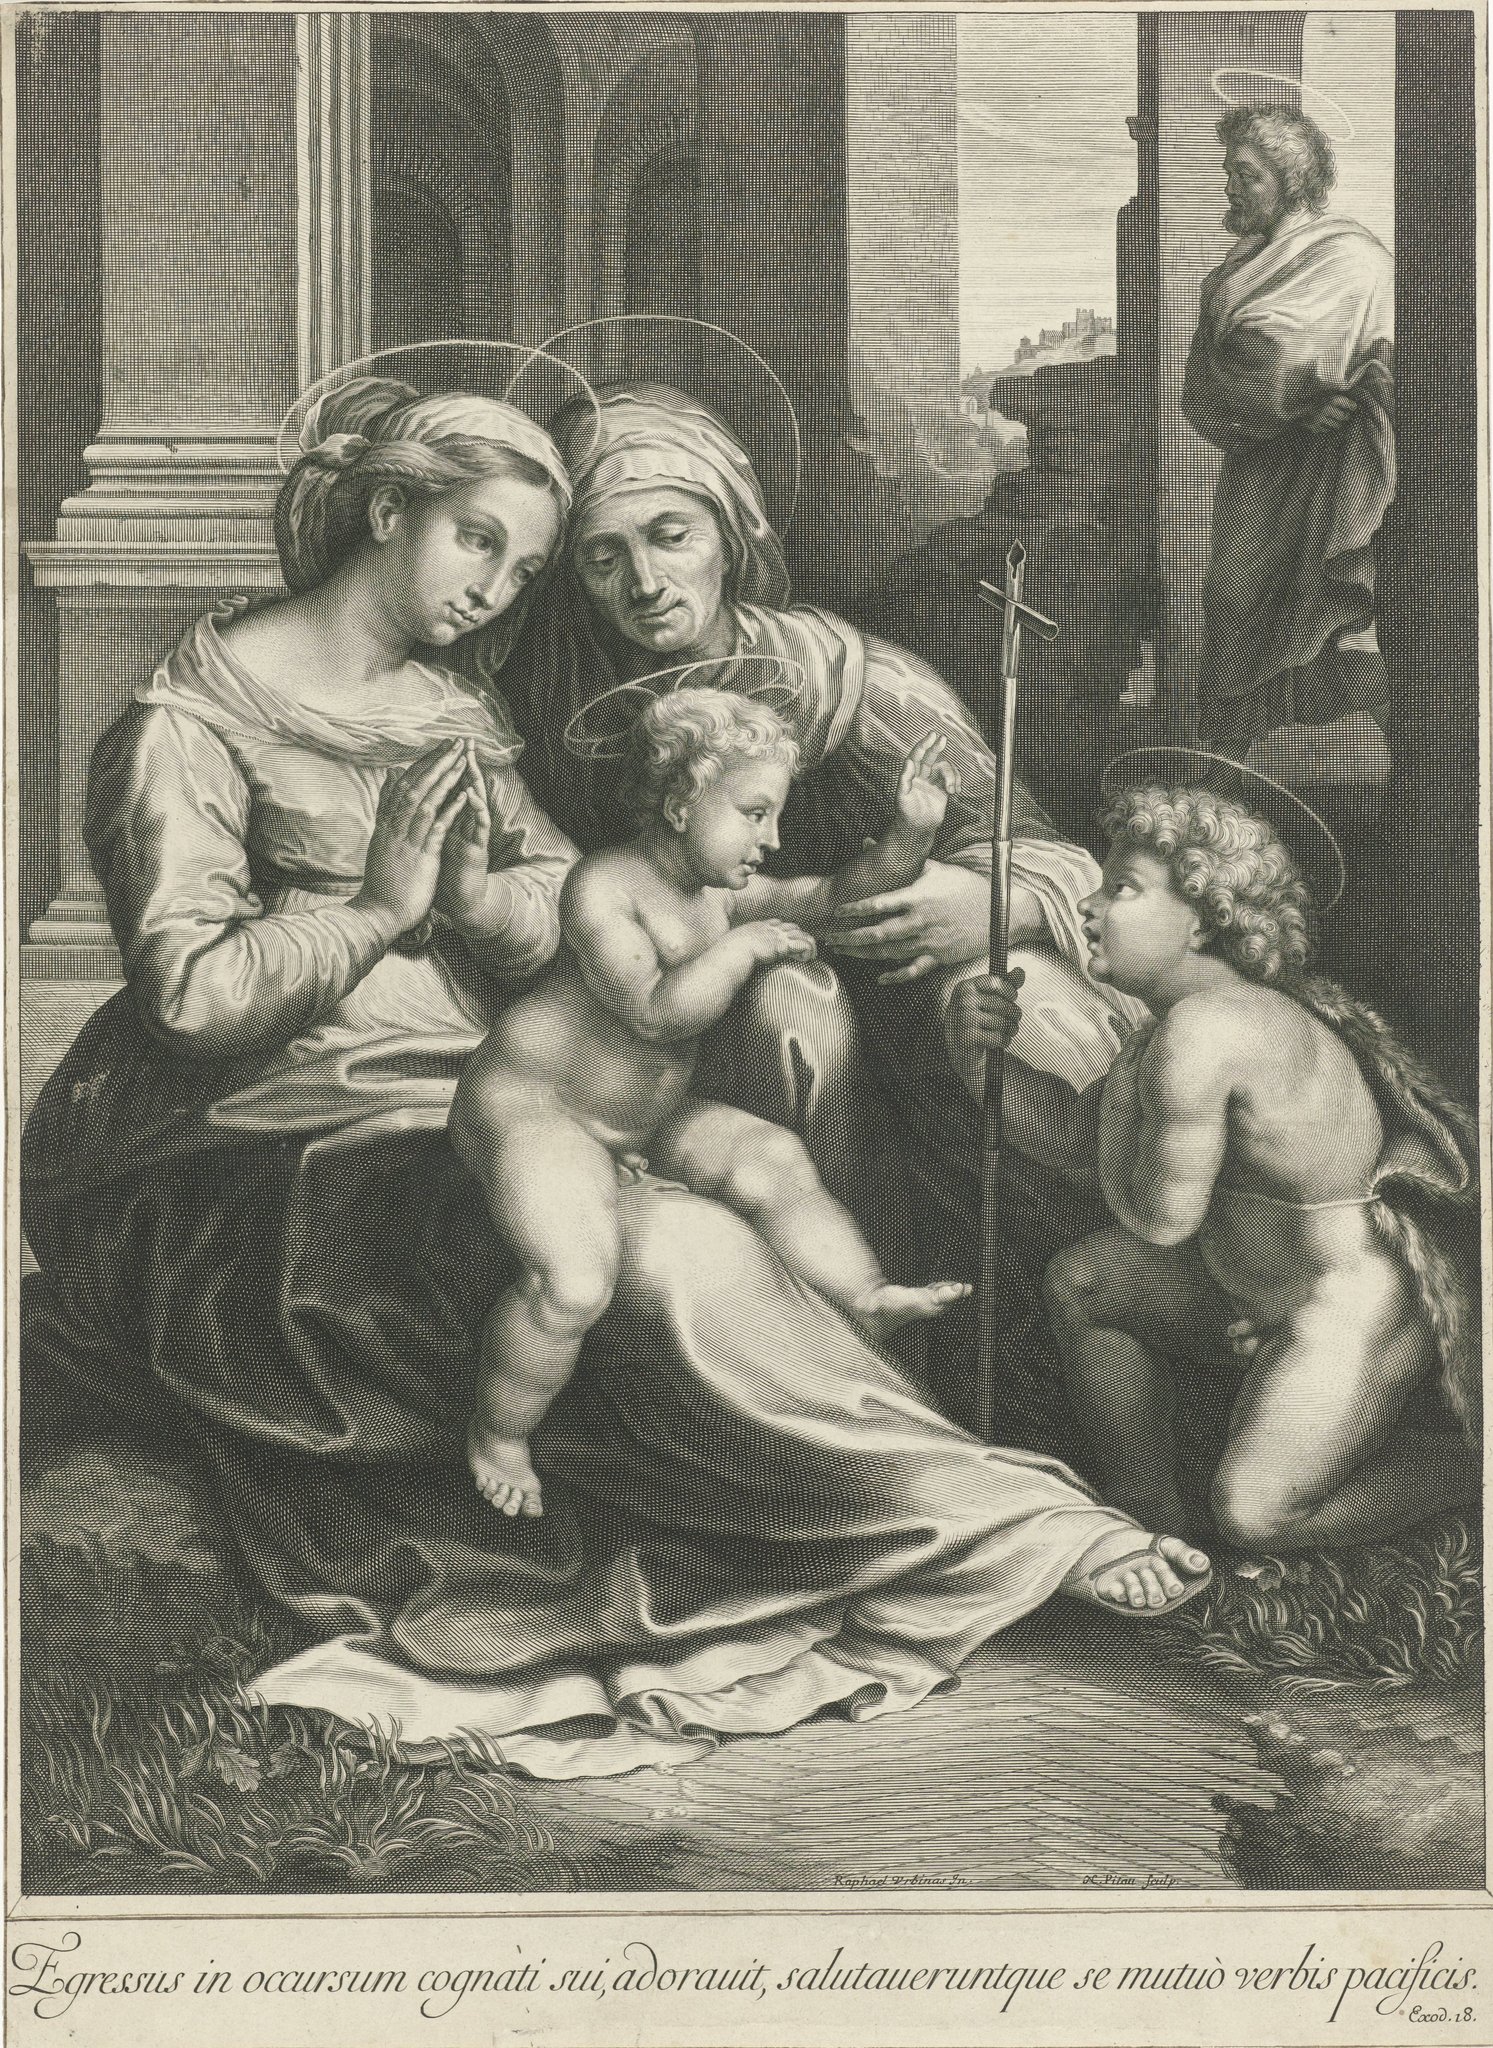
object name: print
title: Heilige Familie met Elisabet en Johannes de Doper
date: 1644-1671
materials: paper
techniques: engraving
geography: paris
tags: holy family with john the baptist, elisabeth present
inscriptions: inscription: ‘A’, collector's mark: Lugt 240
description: Maria zit met het Christuskind op schoot, haar handen gevouwen. Naast haar Elisabet, die de arm van Christus vasthoudt. Hij maakt een zegenend gebaar naar Johannes de Doper, die voor hem knielt. Op de achtergrond Jozef. In de marge een Bijbelcitaat uit Ex. 18 in het Latijn.